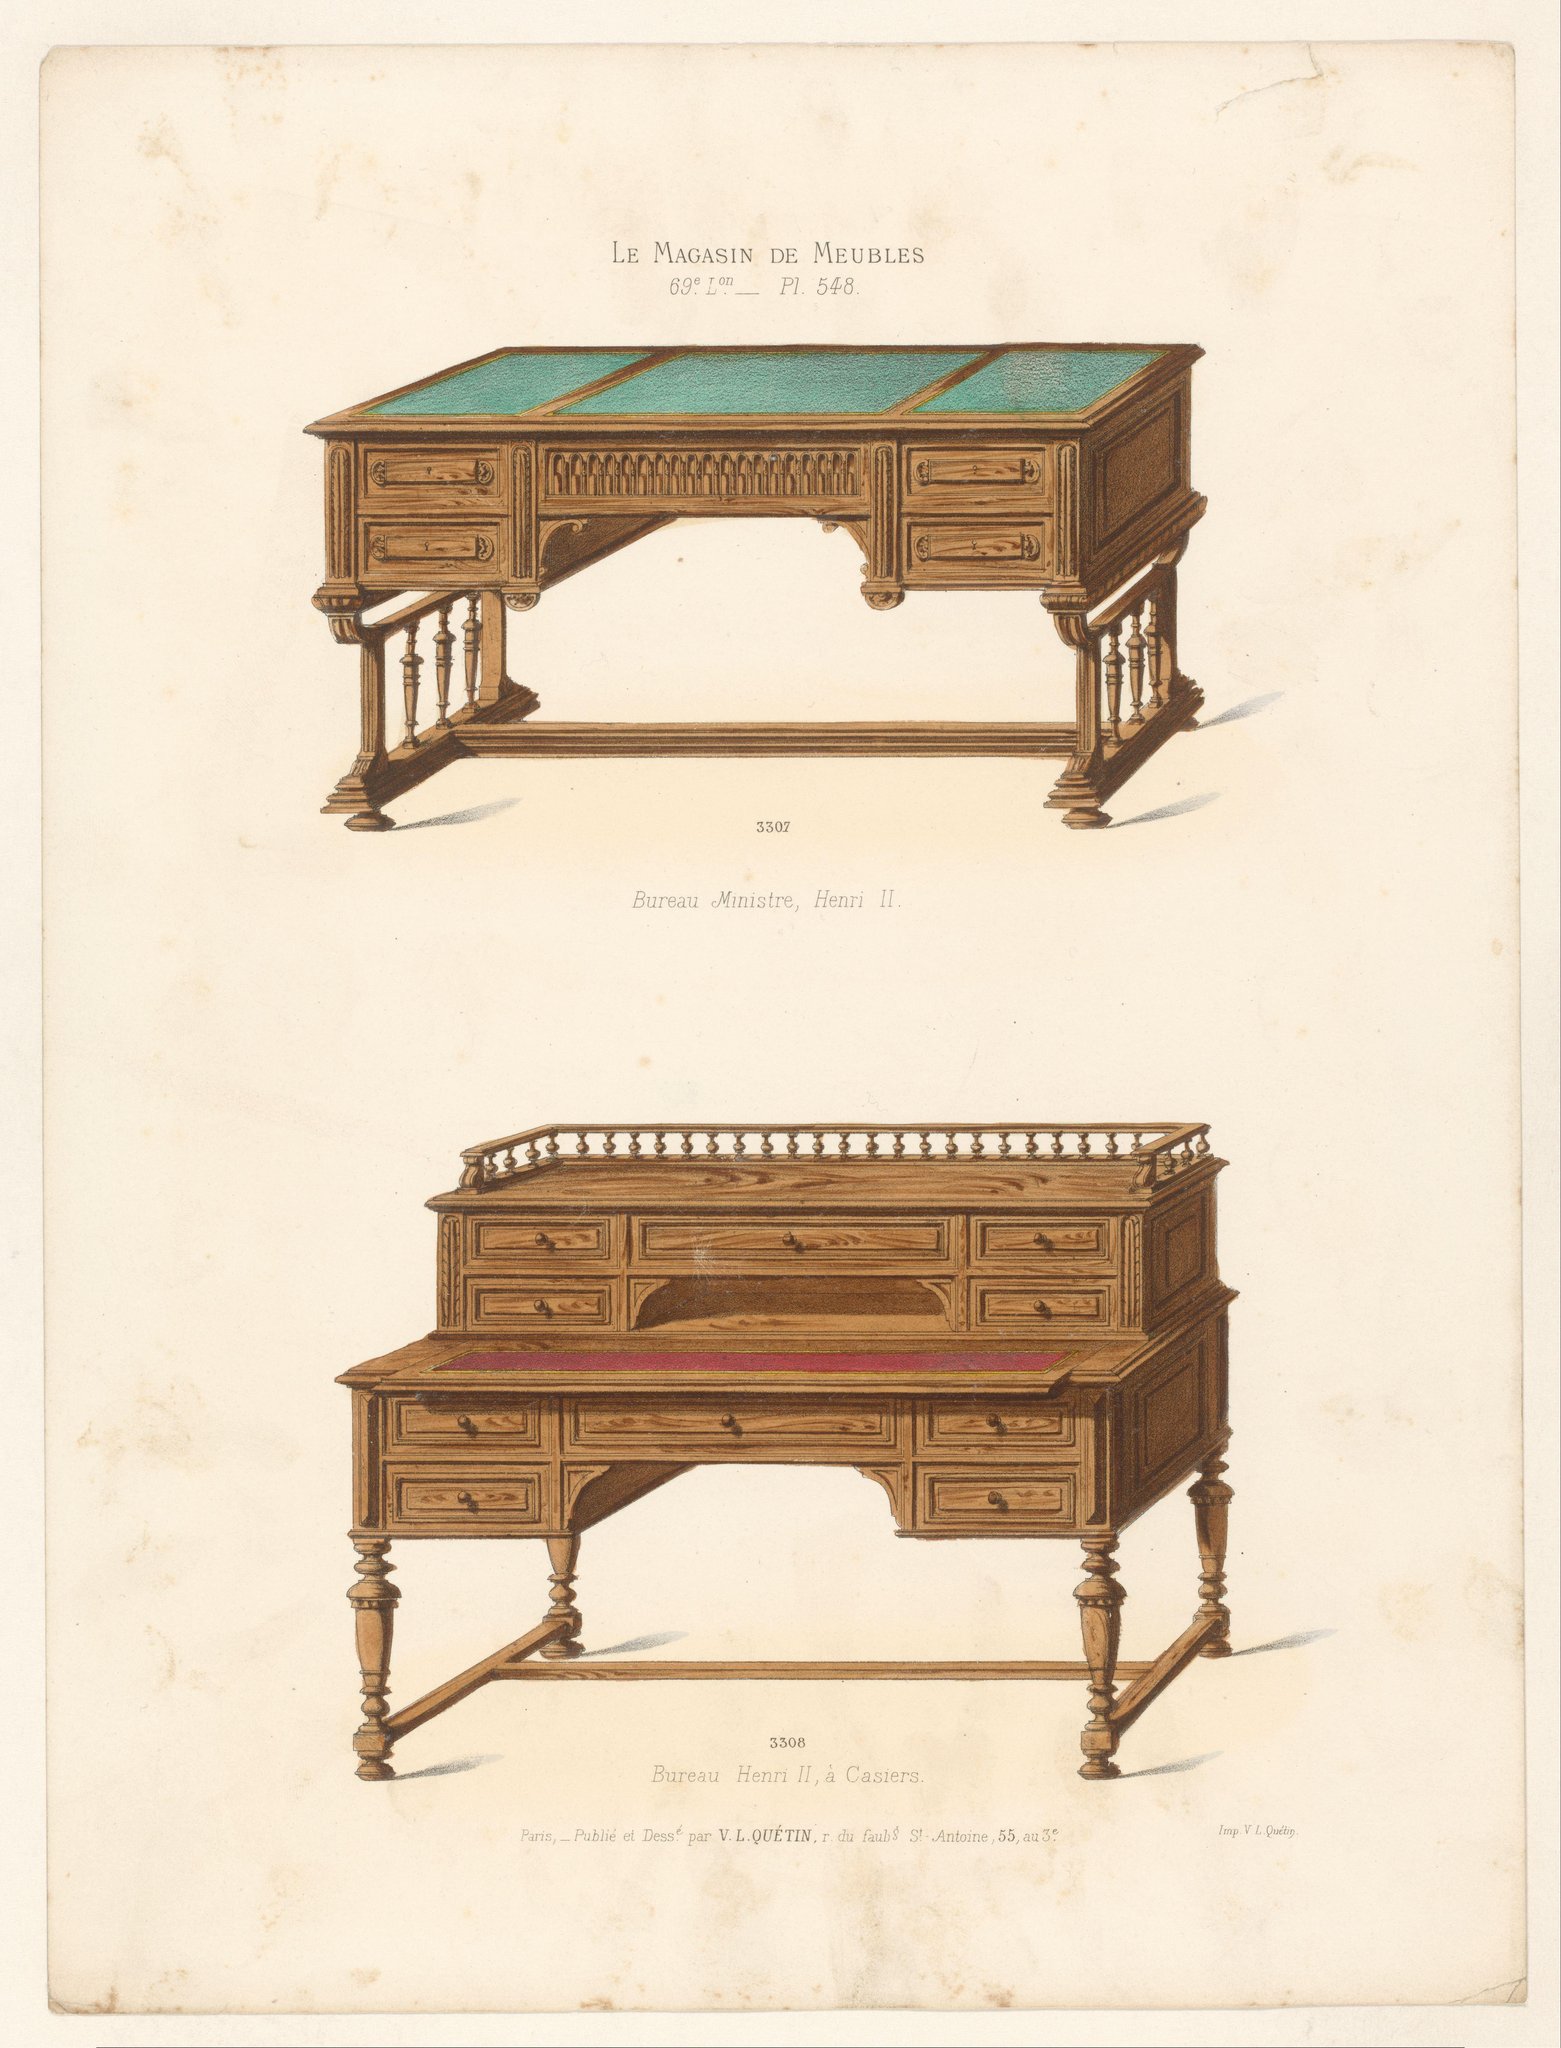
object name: print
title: Le Magasin de Meubles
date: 1878-1904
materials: paper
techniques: hand coloring, lithograph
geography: paris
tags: writing-table, writing-desk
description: Twee bureaus in de Hendrik II-stijl. Prent uit 69e Livraison.